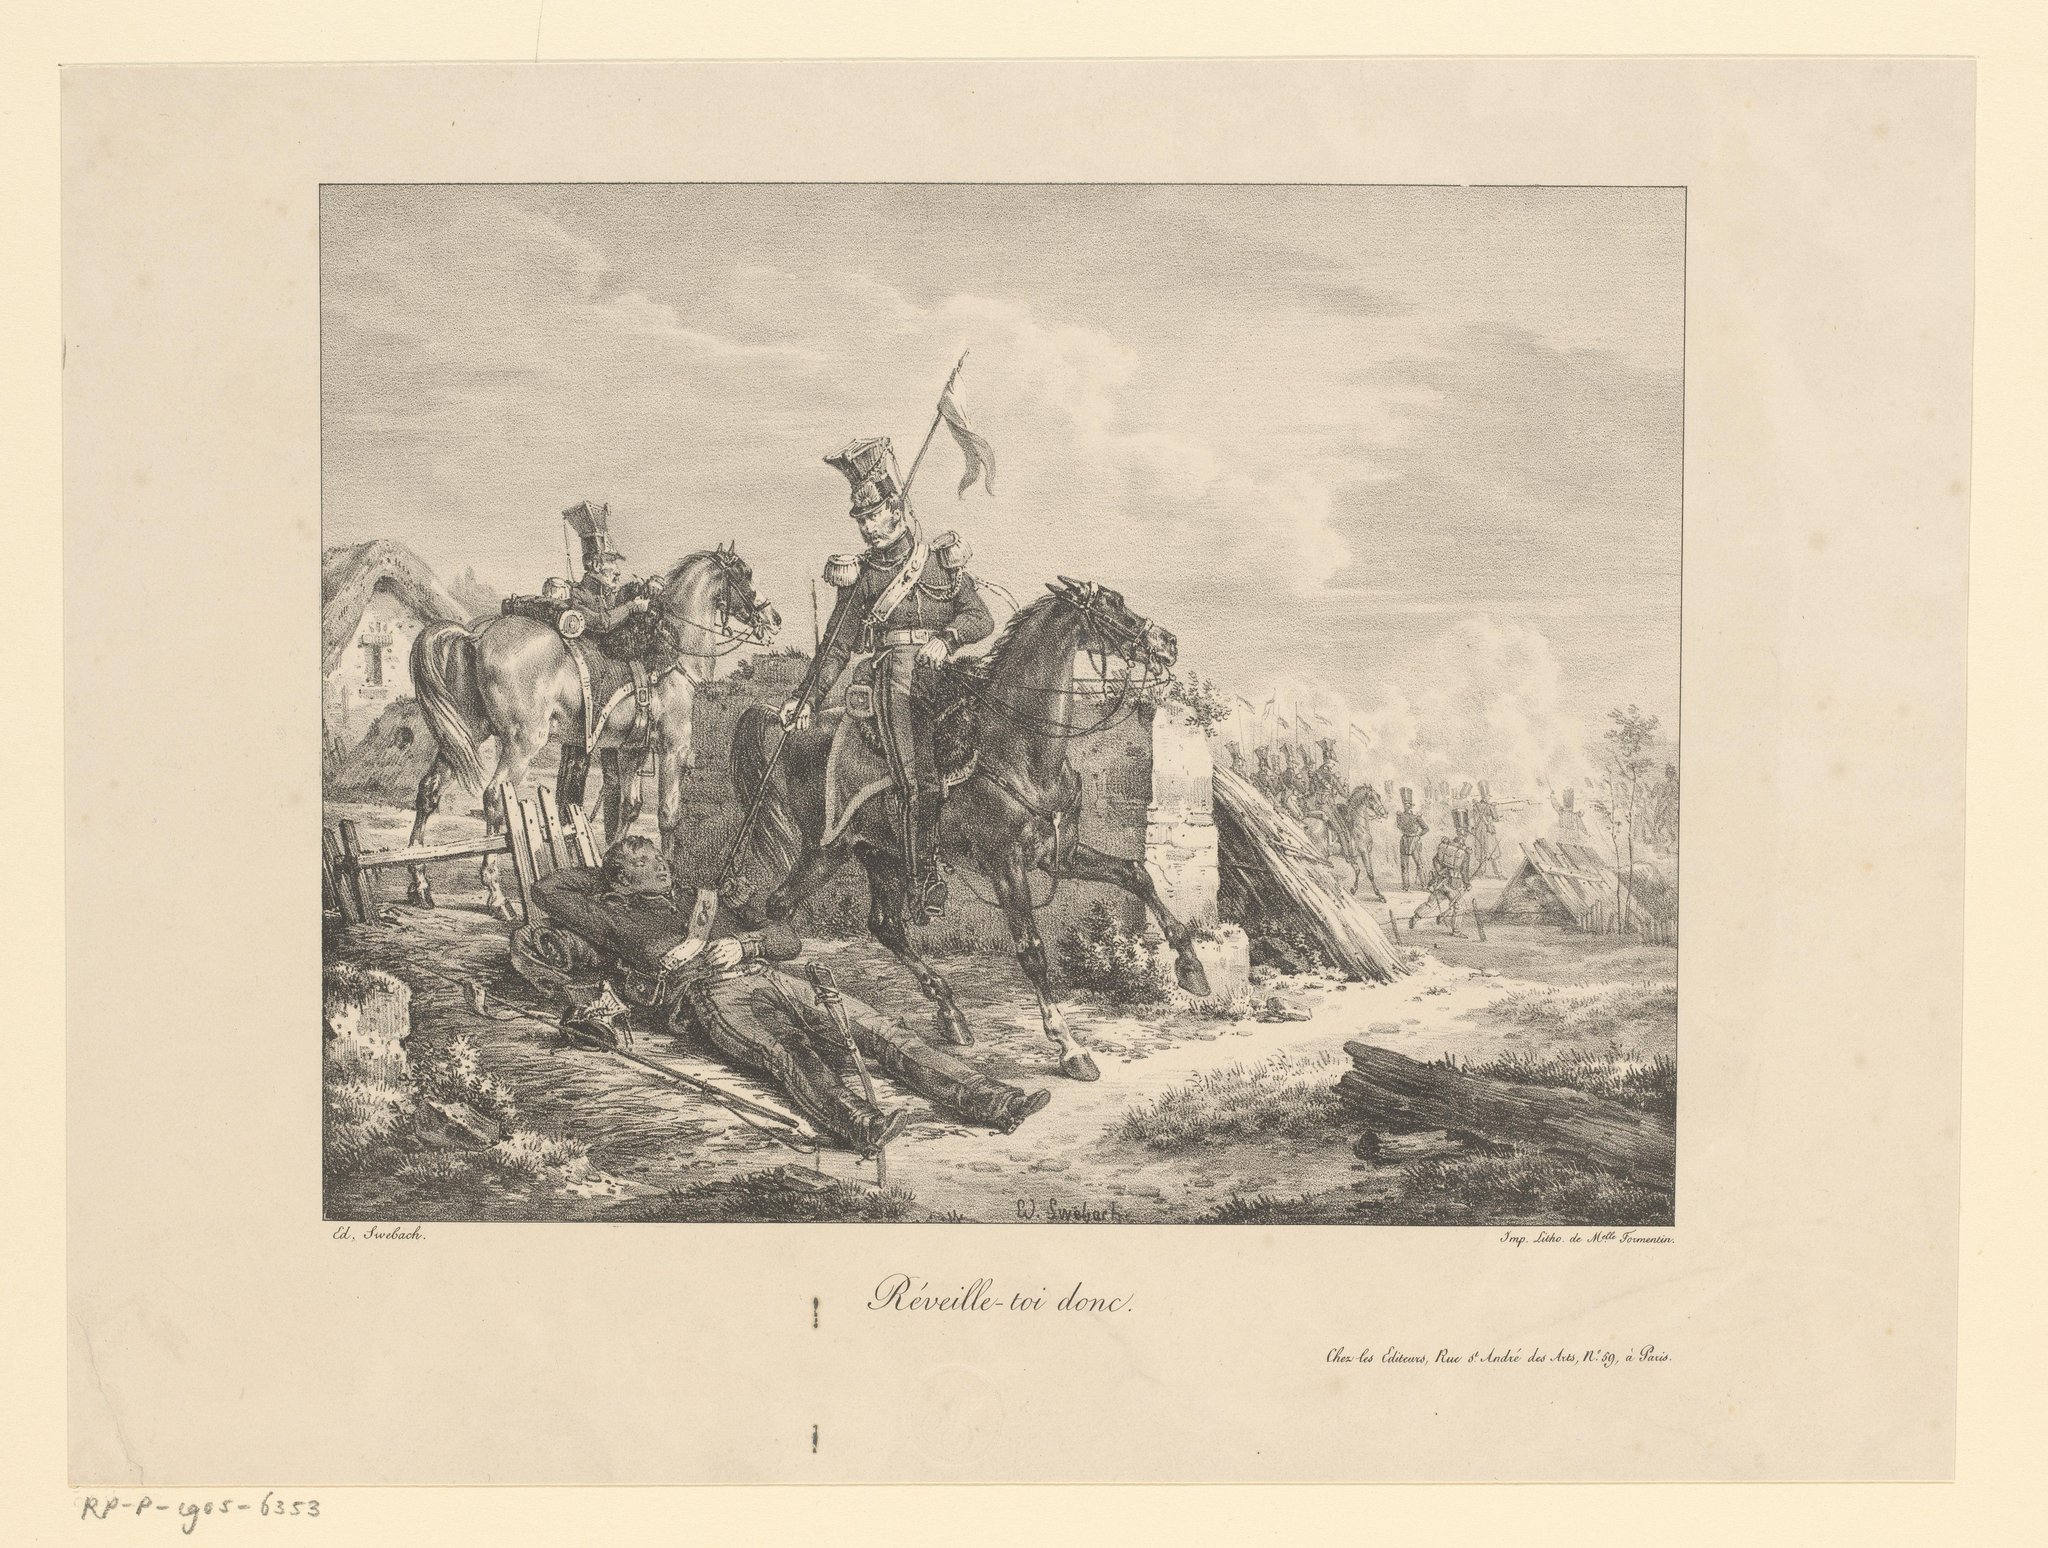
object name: print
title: Militair te paard richt zich tot liggende man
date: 1822-1856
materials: paper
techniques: lithograph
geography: paris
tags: warfare; military affairs (+ cavalry, horsemen)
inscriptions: collector's mark: Lugt 2228, check stamp: Lugt 3856